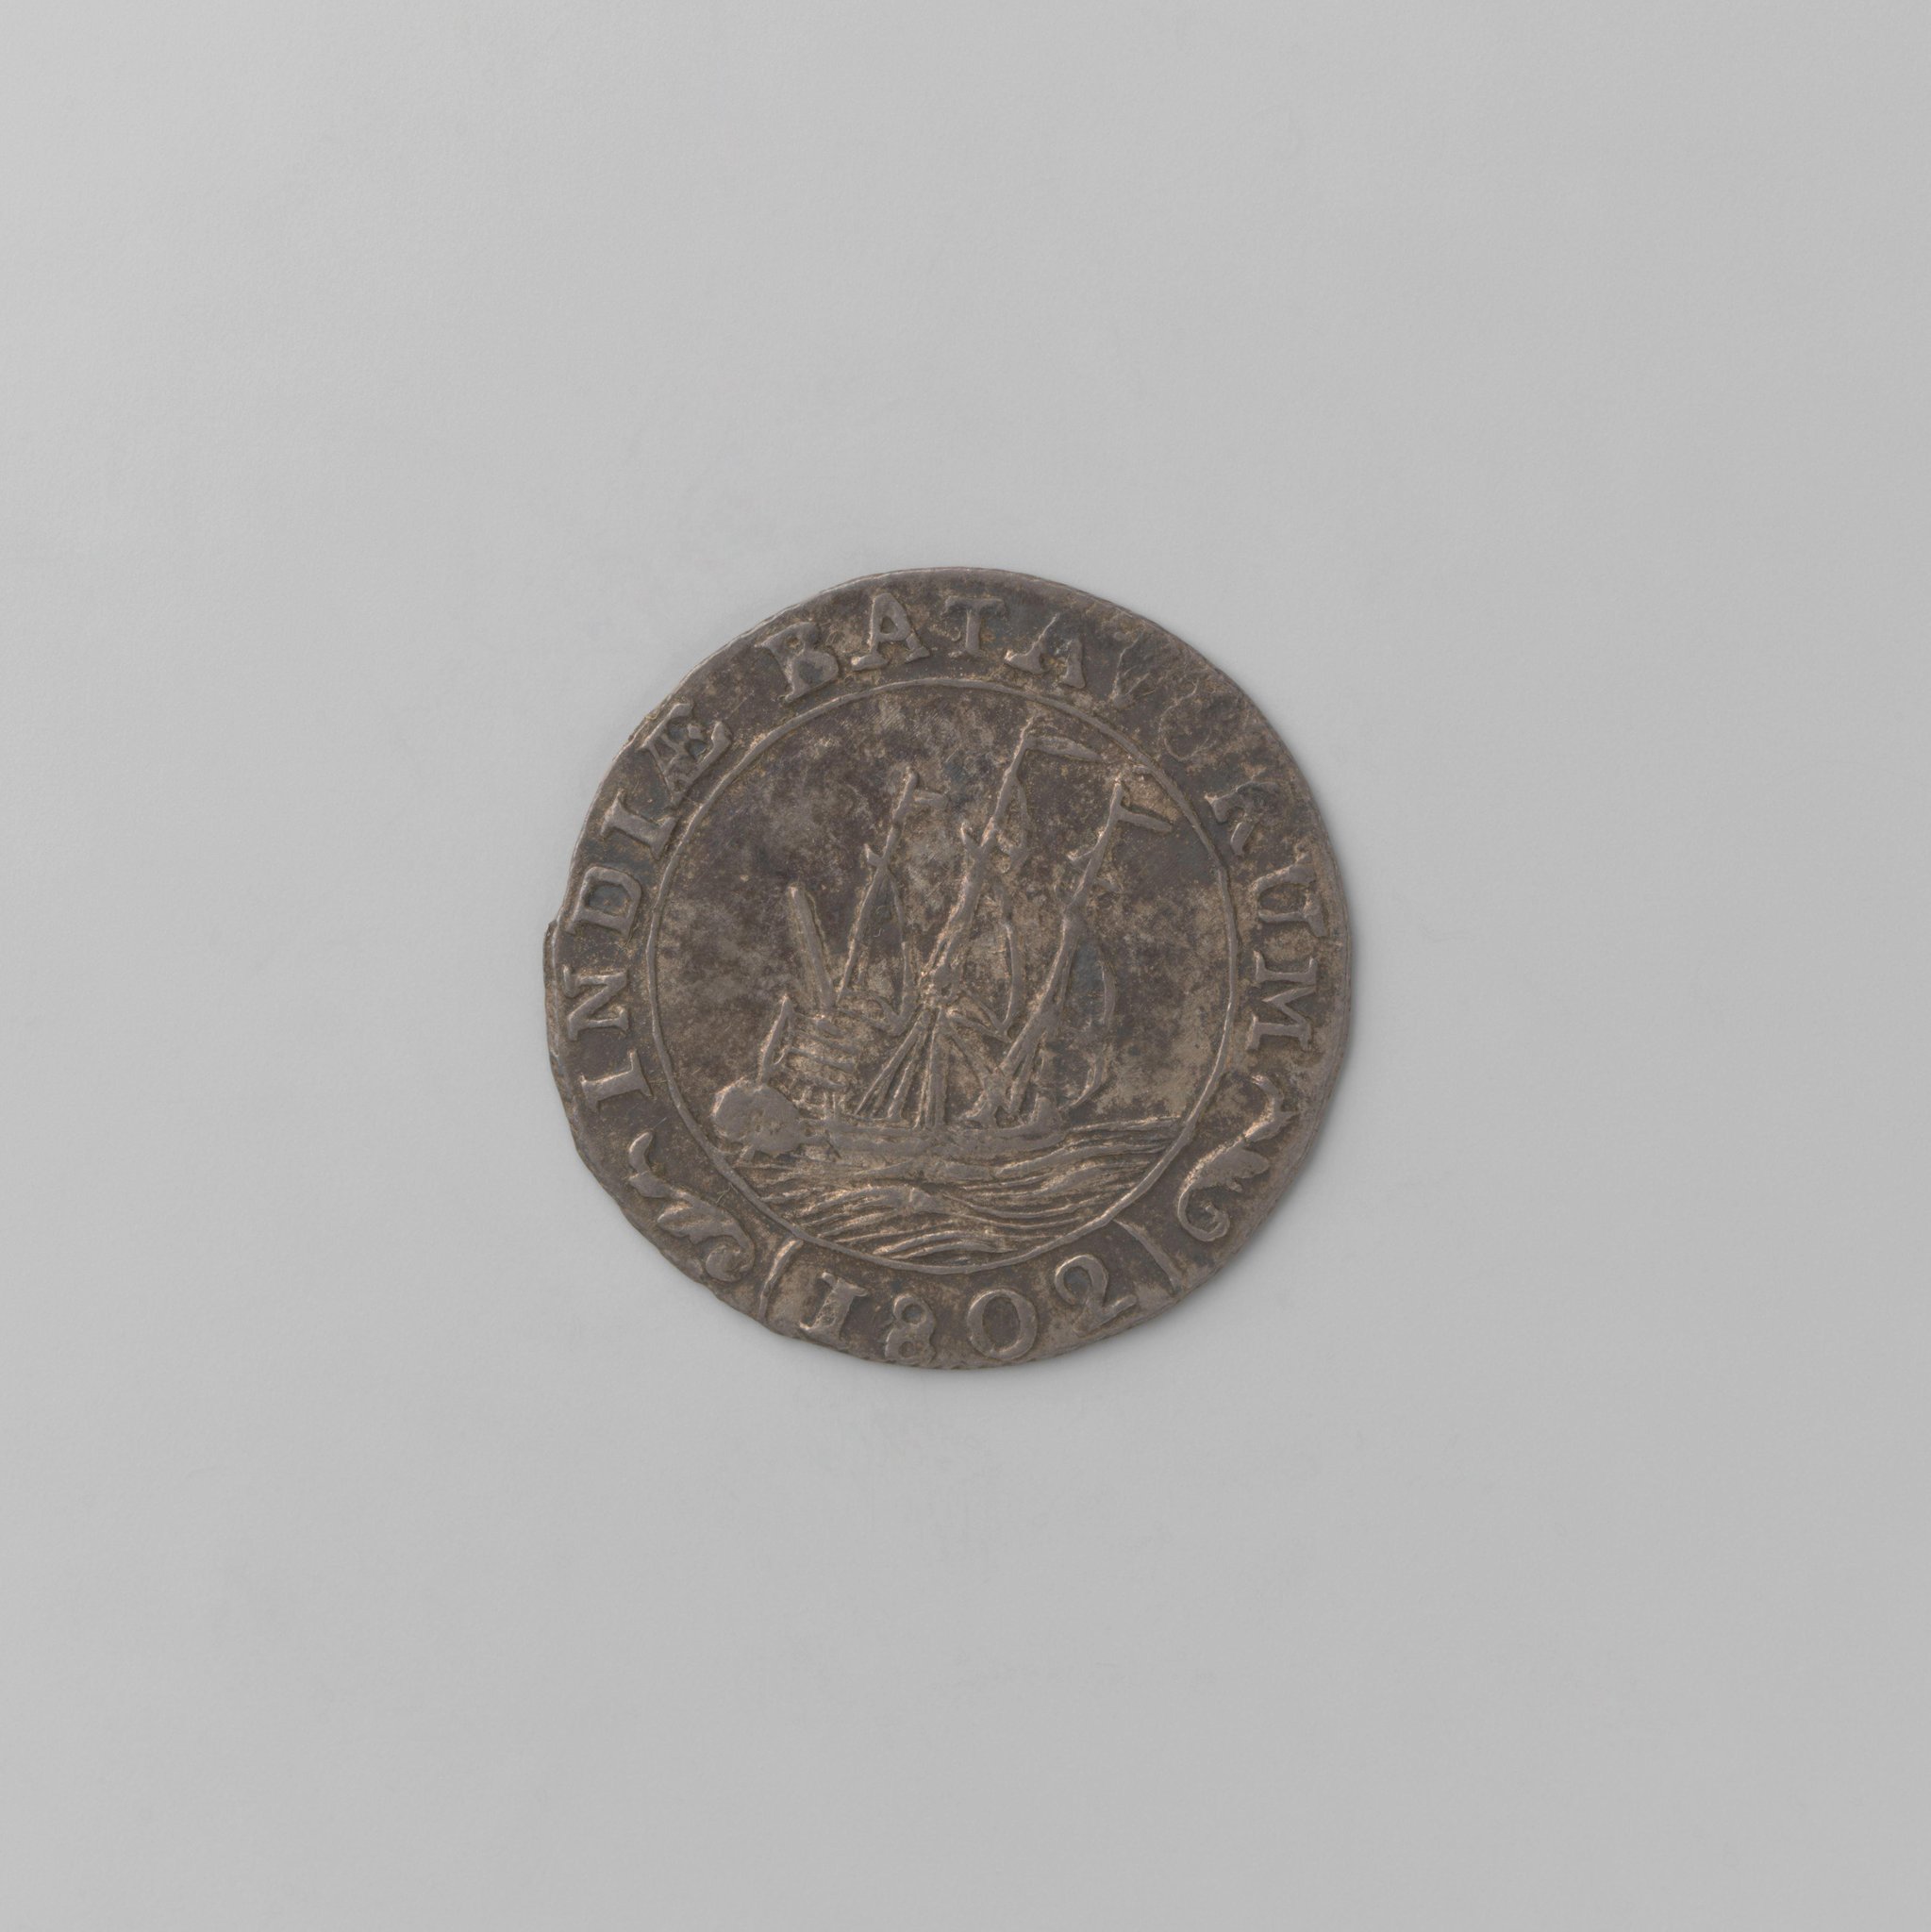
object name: coin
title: 1/16 scheepjesgulden, 1802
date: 1802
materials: silver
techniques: striking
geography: enkhuizen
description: Zilveren munt. Voorzijde: binnen cirkel driemaster met volle zeilen op open zee. Versierd jaartal onderaan in omschrift. Keerzijde: tussen waarde-aanduiding 1/16 G gekroond generaliteitswapenschild. Muntteken boven kroon in omschrift. Gladde rand.